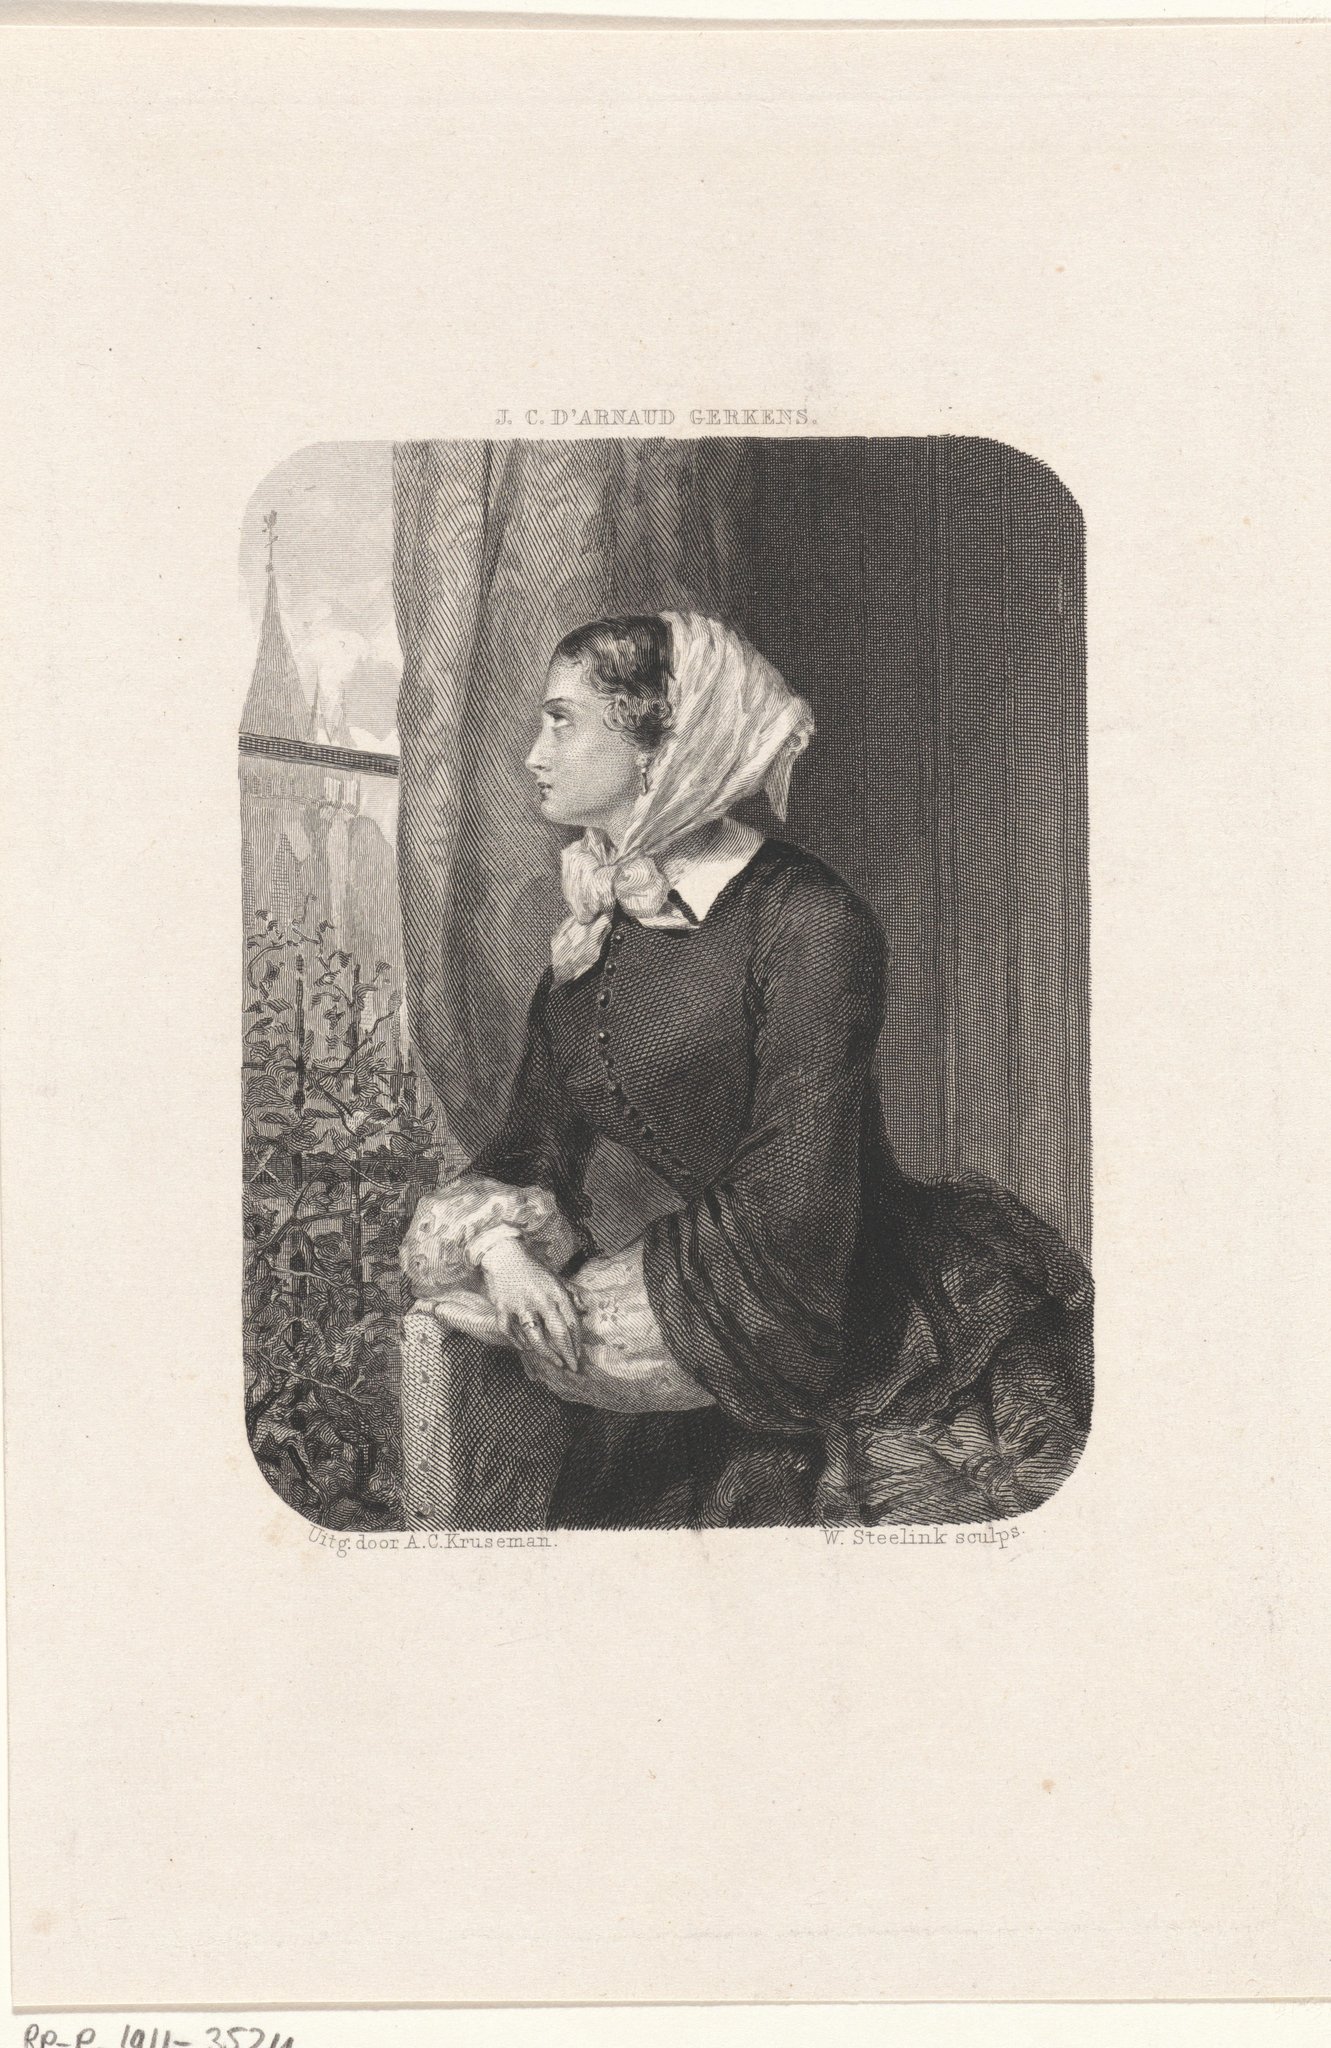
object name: print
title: Het haantje van de toren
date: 1859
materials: paper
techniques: etching, engraving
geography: haarlem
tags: adult woman, contemplation, parts of church exterior and annexes: tower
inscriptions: collector's mark: Lugt 2228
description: Een zieke vrouw kijkt uit het raam naar de haan op de kerktoren. Illustratie bij een gedicht van P.A. de Genestet.